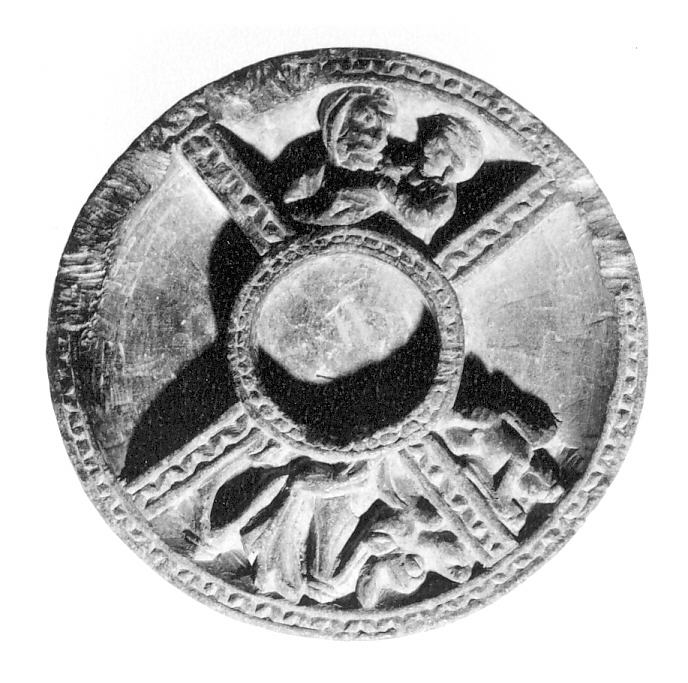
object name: dish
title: Dish with Five Sections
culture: gandhara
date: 1-100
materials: stone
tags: gandhara